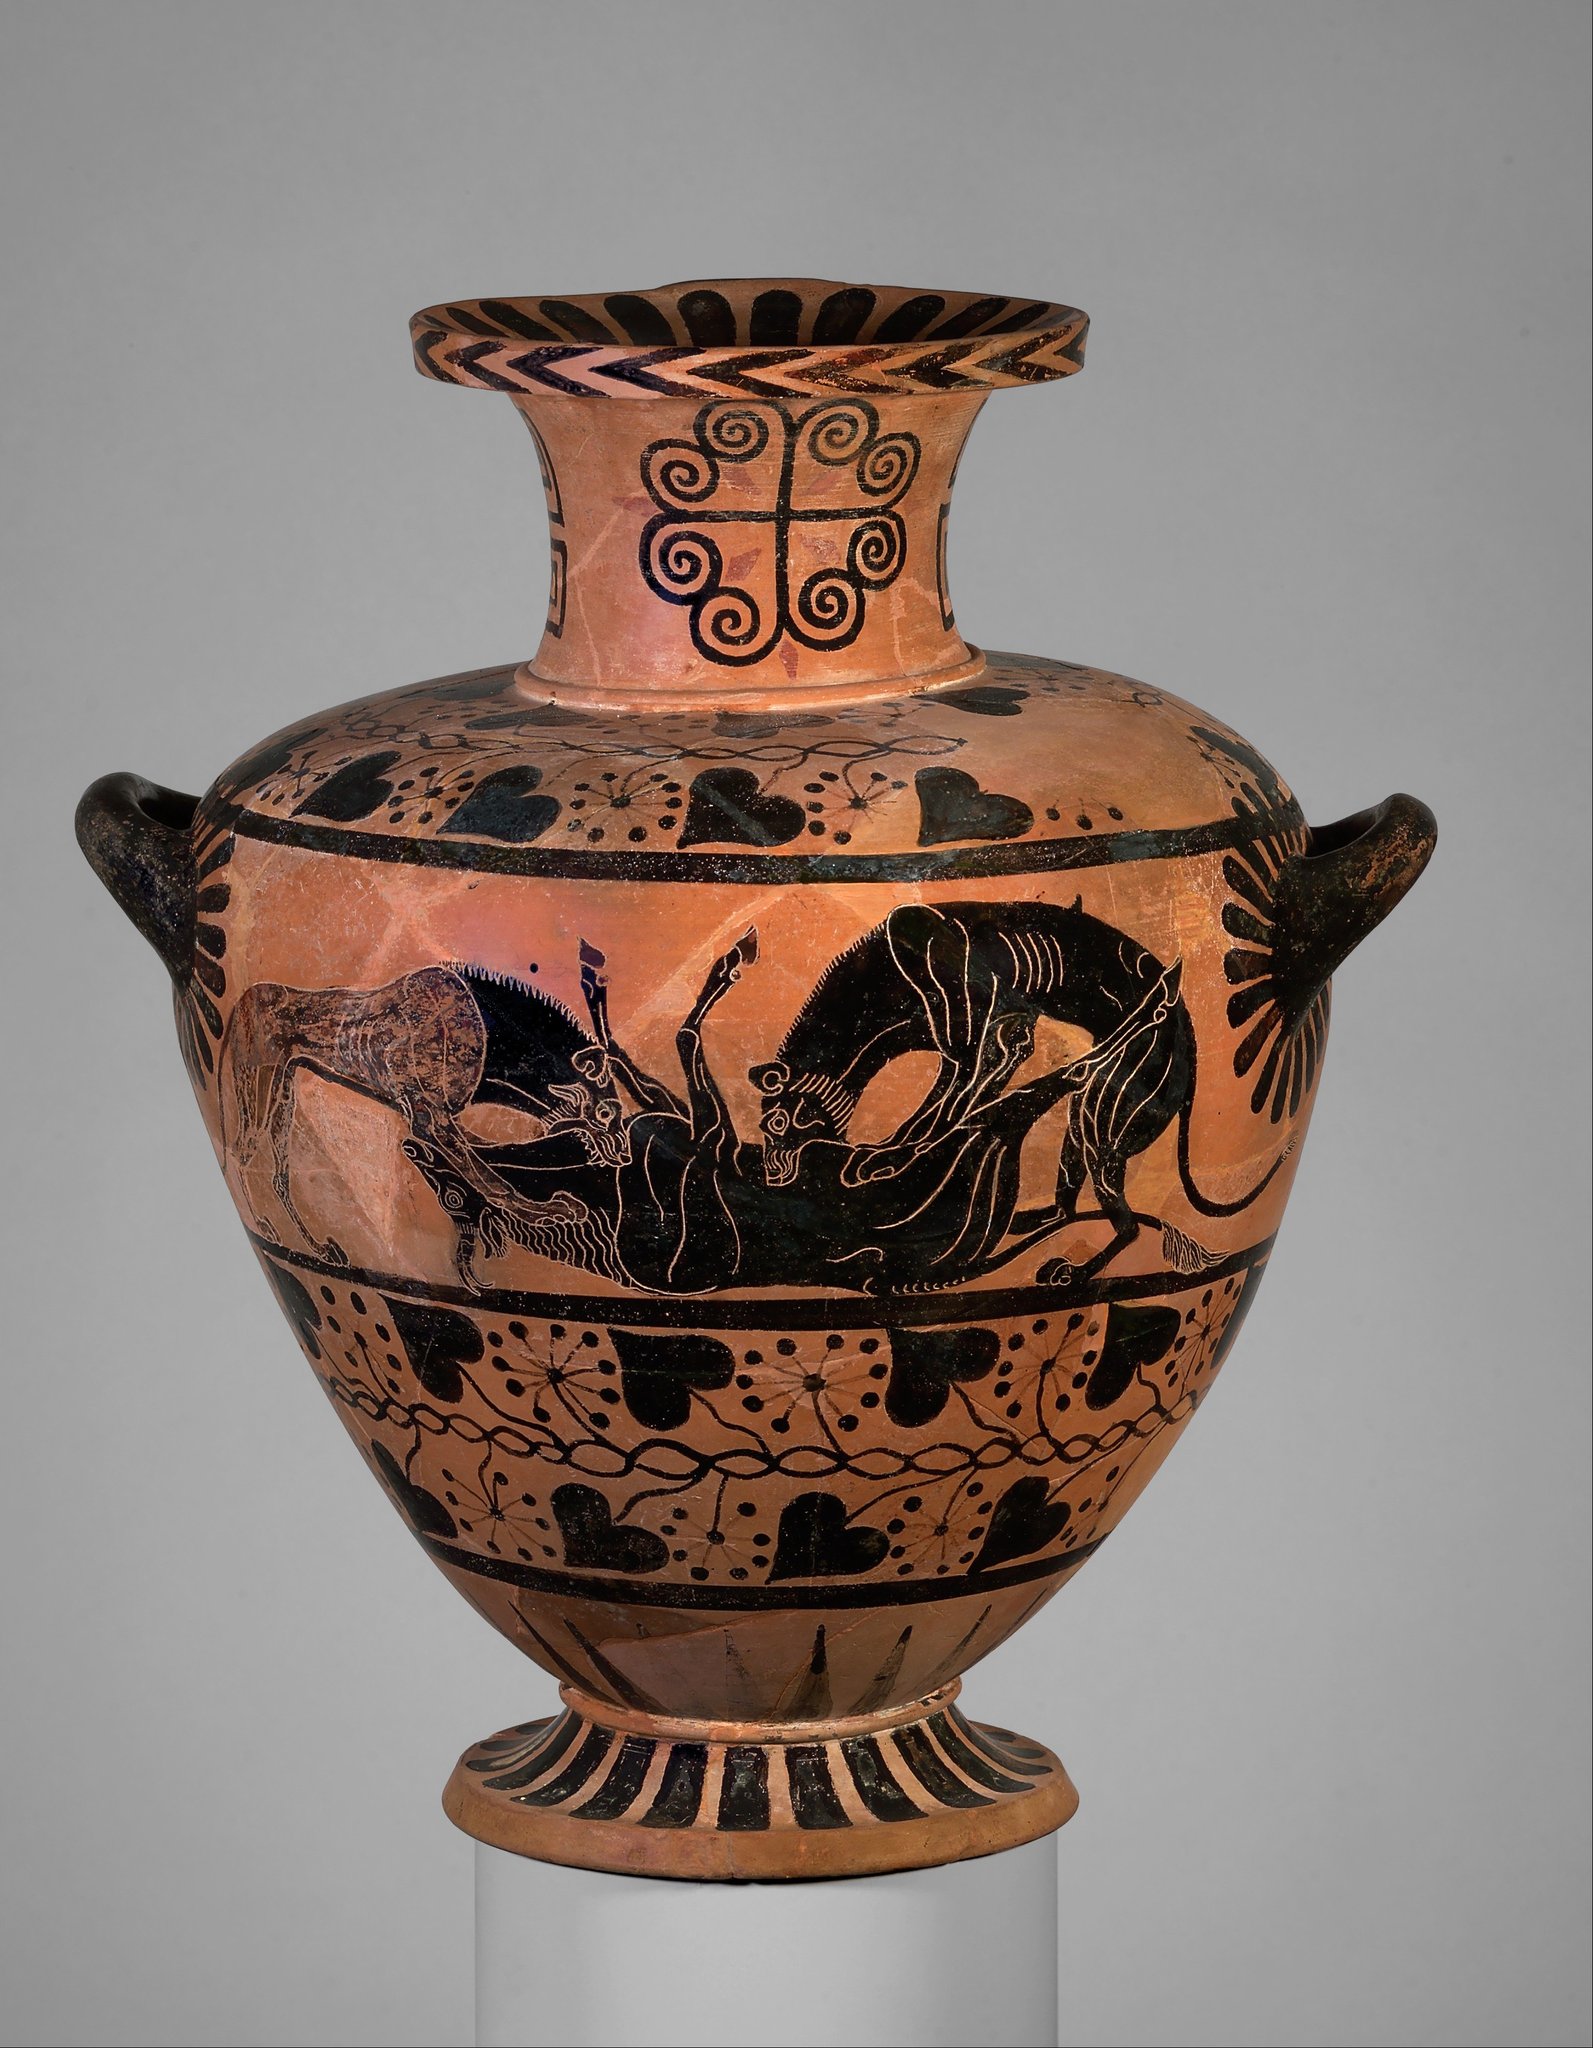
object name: hydria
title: Terracotta hydria (water jar)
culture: greek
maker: eagle painter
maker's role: artist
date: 520-510 BCE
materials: terracotta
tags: bulls,horses,leopards,lions